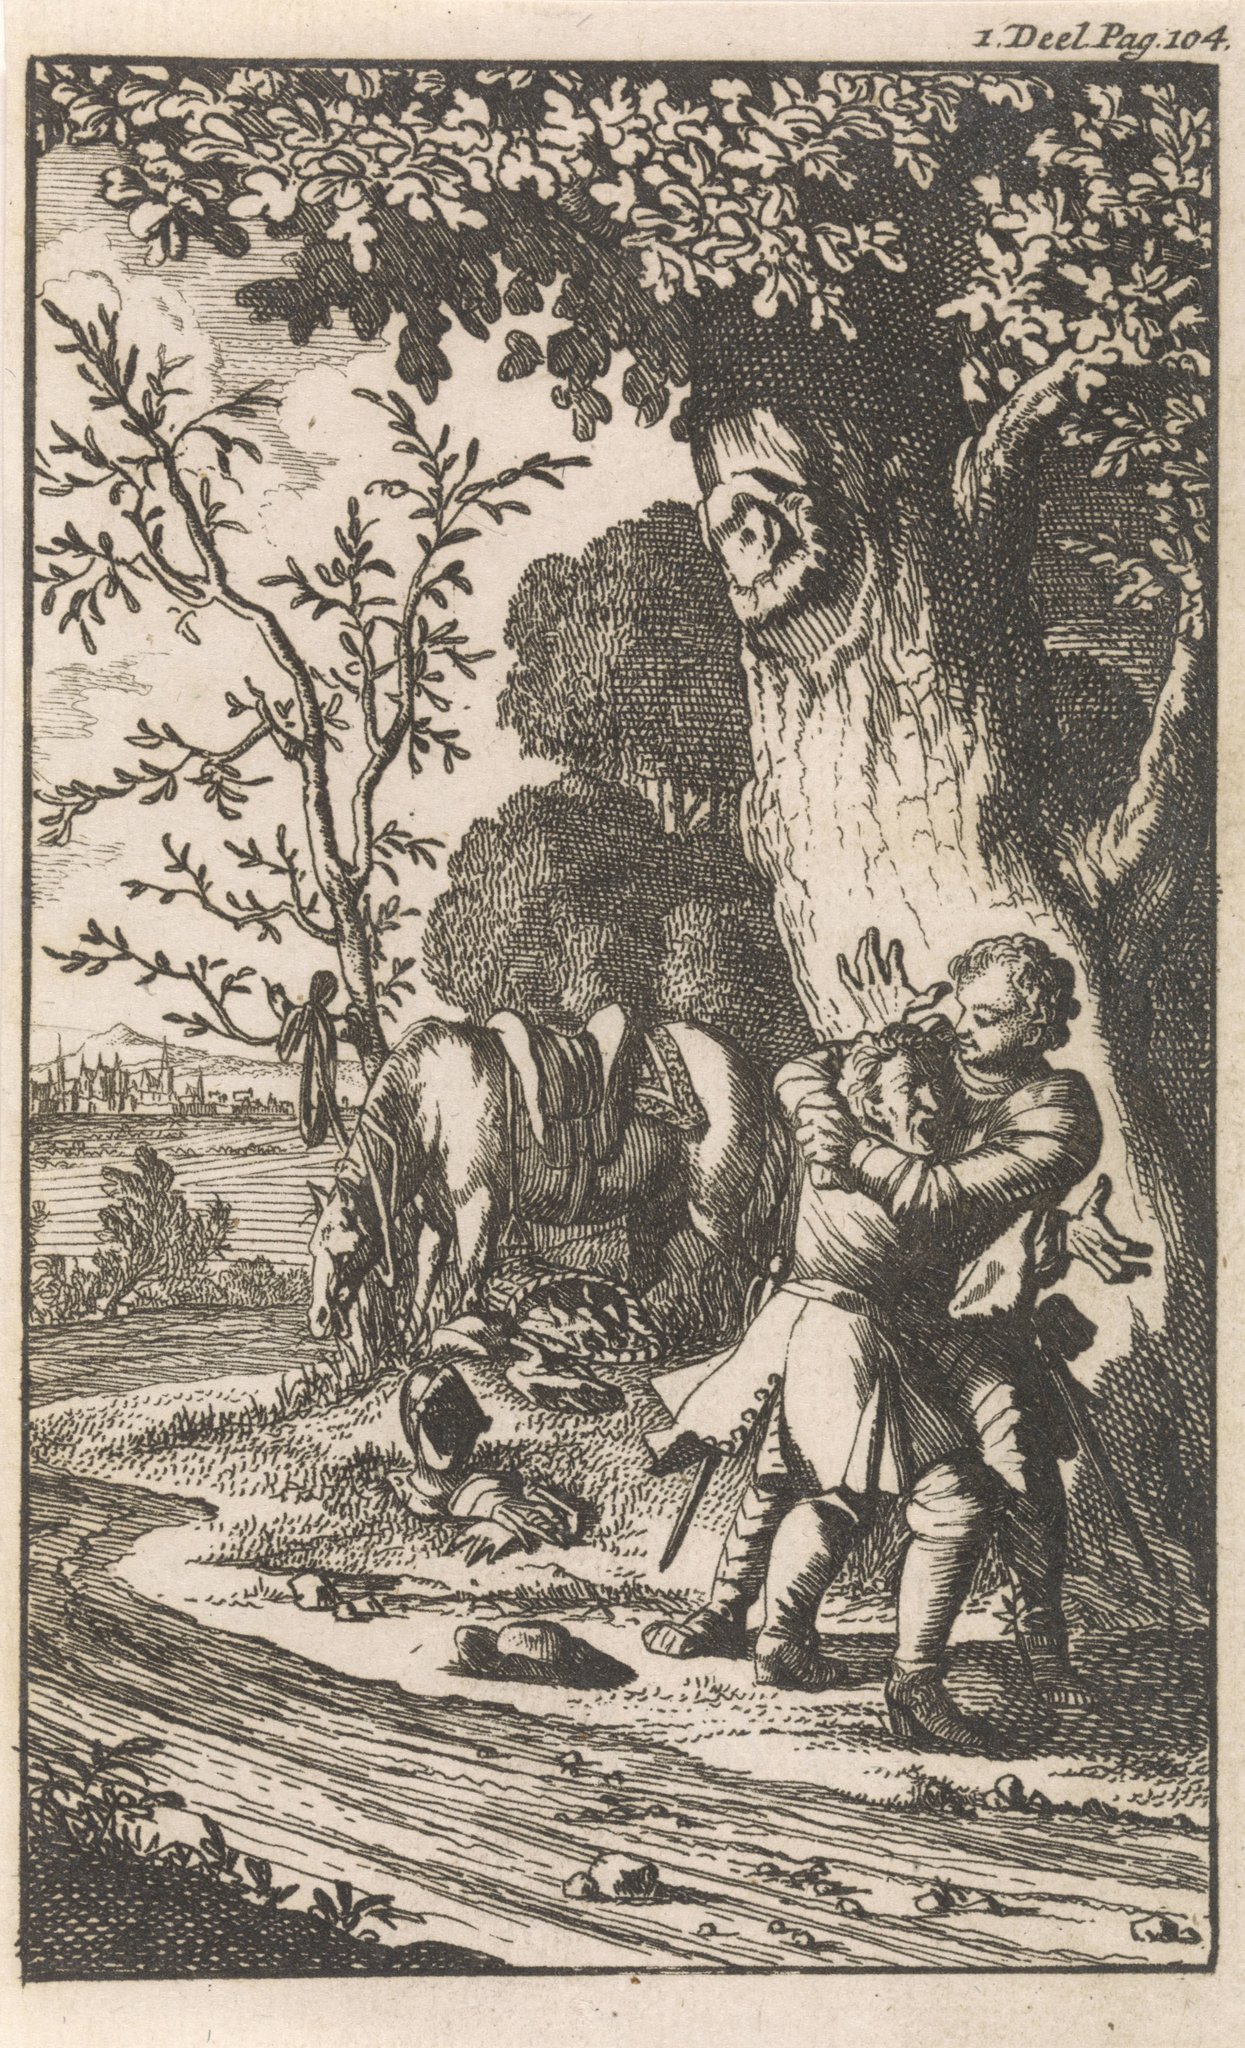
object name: book illustration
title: Don Clarazel omhelst Gandales, die hij tot zijn schildknaap kiest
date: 1697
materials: paper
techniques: etching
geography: amsterdam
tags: shield-bearer, squire, embracing each other, kissing, knight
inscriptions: collector's mark: Lugt 2228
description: Illustratie uit: Verdier, Gilbert Saulnier du (vert. Heinsius, Nicolaas junior). Don Clarazel de Gontarnos, ofte den buiten-spoorigen dolenden ridder, 2 delen. Amsterdam: Johannes Broersz en Nathanael Holbeex, 1697, dl. 1.